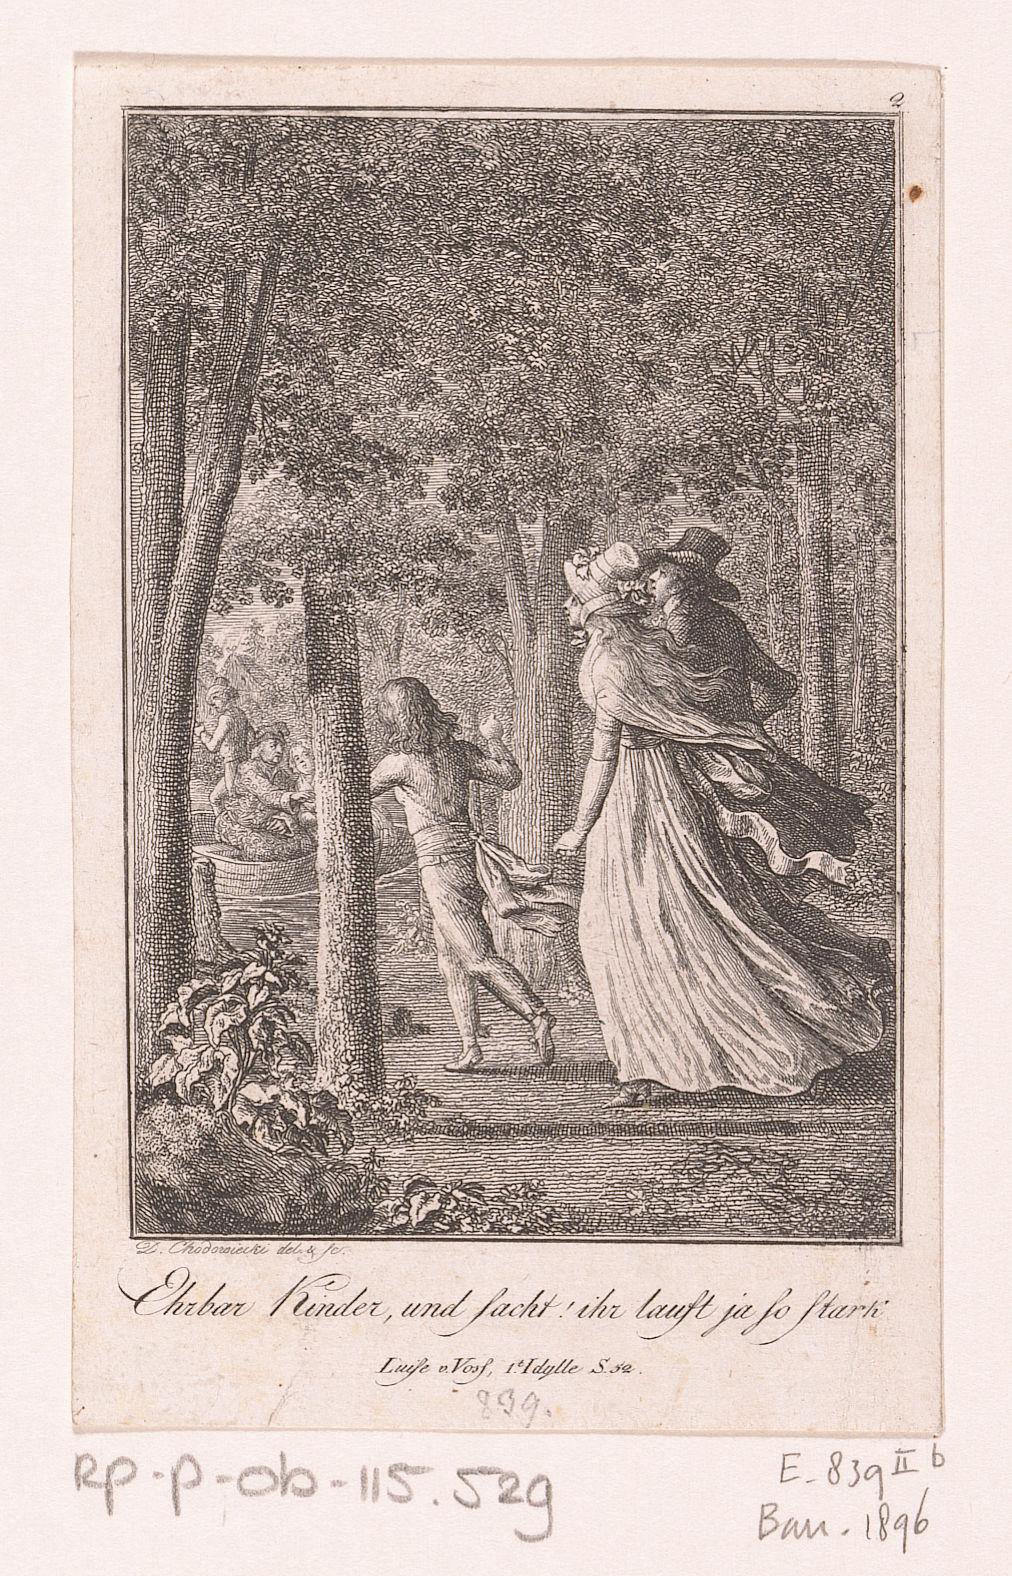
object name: print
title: Luise wordt getrakteerd op een picknick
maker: daniel nikolaus chodowiecki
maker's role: draughtsman, print maker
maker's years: 1726-1801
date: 1797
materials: paper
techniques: etching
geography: berlin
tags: literature, forest, wood, picnic, alfresco, 'déjeuner sur l'herbe'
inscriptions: collector's mark: Lugt 2228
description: Prent gebruikt voor: Becker, Wilhelm Gottlieb. Almanach und Taschenbuch zum geselligen Vergnügen von W. G. Becker für 1798. Leipzig: Voss und Comp., [1797].